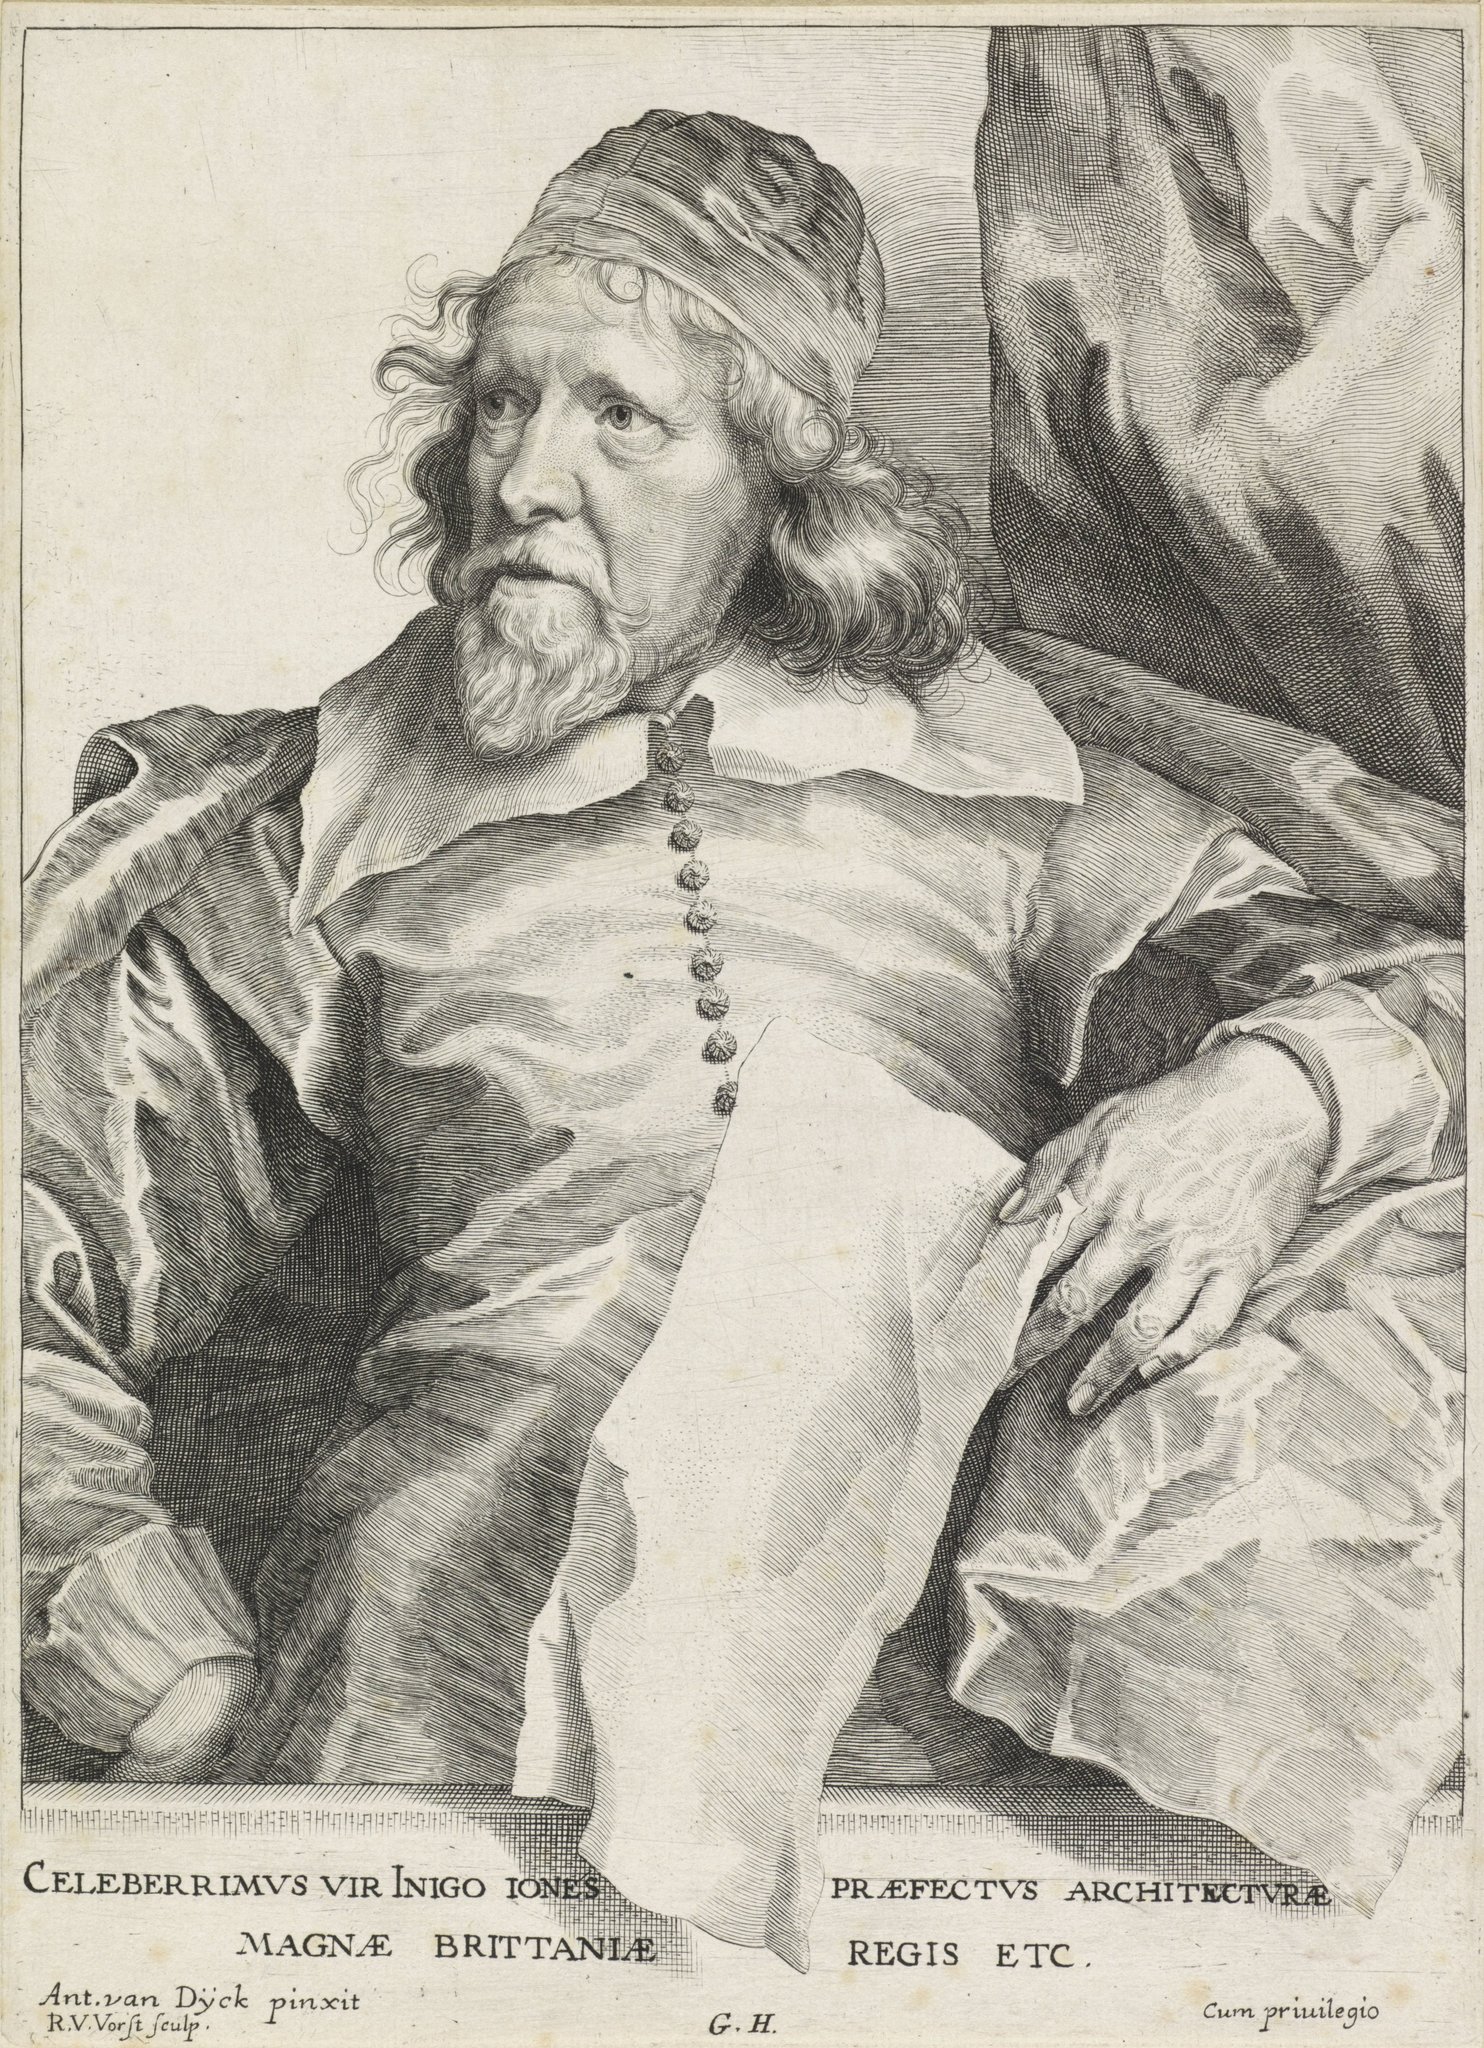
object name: print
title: Portret van Inigo Jones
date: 1627-1636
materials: paper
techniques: engraving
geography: antwerp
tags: london, physicist, paper (writing material)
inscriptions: collector's mark: Lugt 240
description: Portet van de Engelse architect Inigo Jones. In zijn hand een vel papier.